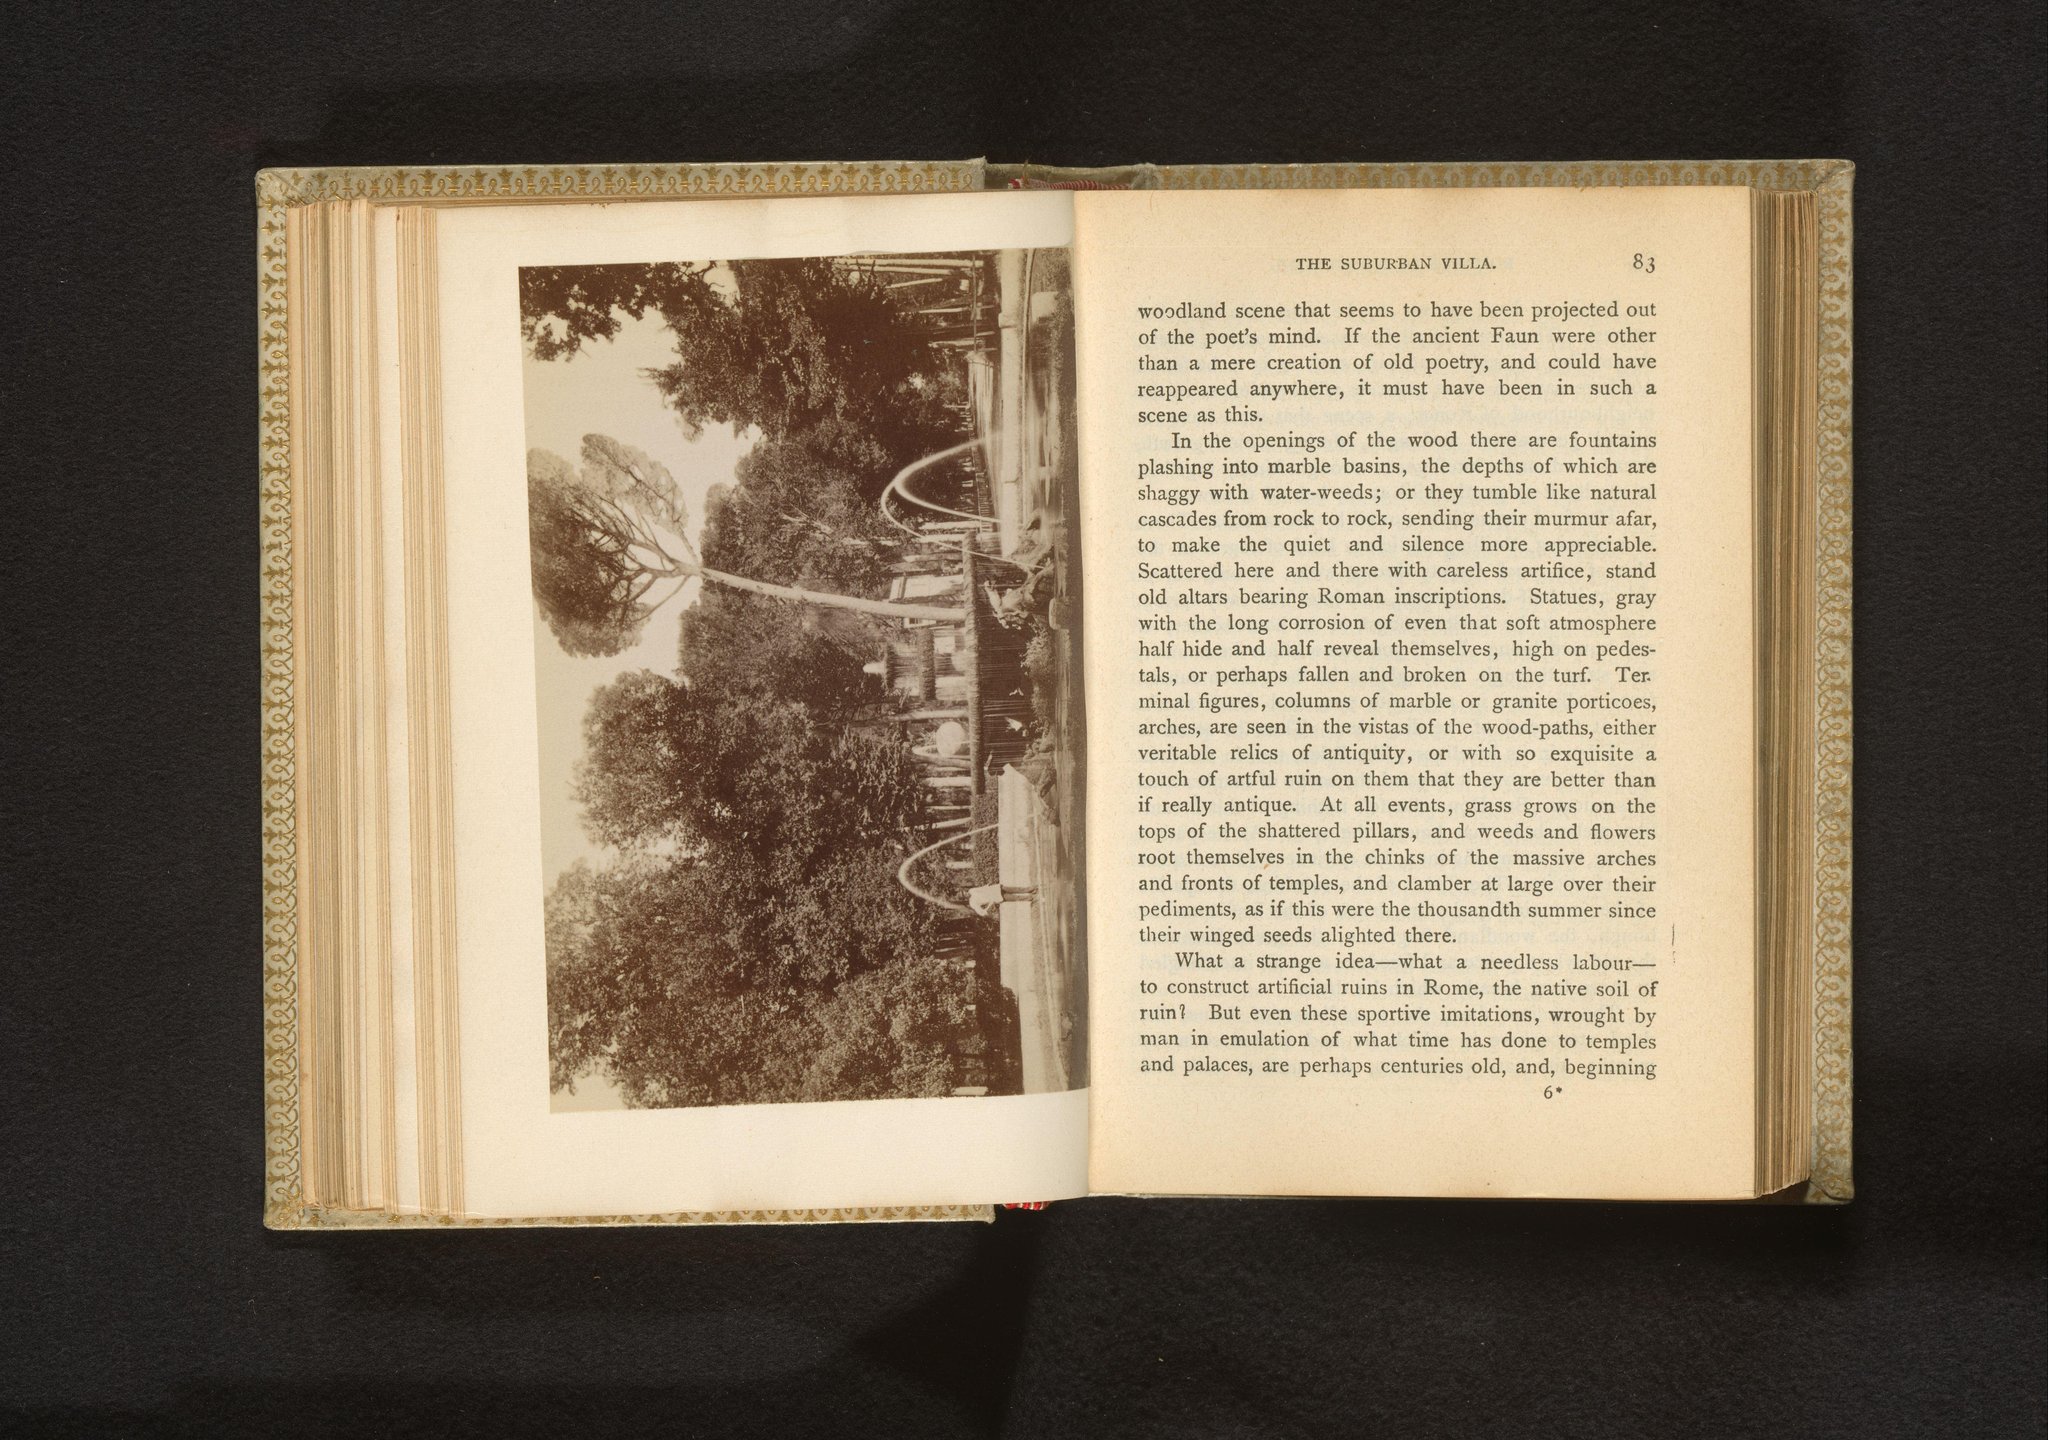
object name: page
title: Fontein in de tuin van Villa Borghese in Rome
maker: Anonymous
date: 1850-1860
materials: photographic support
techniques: albumen print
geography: rome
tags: garden, garden fountain